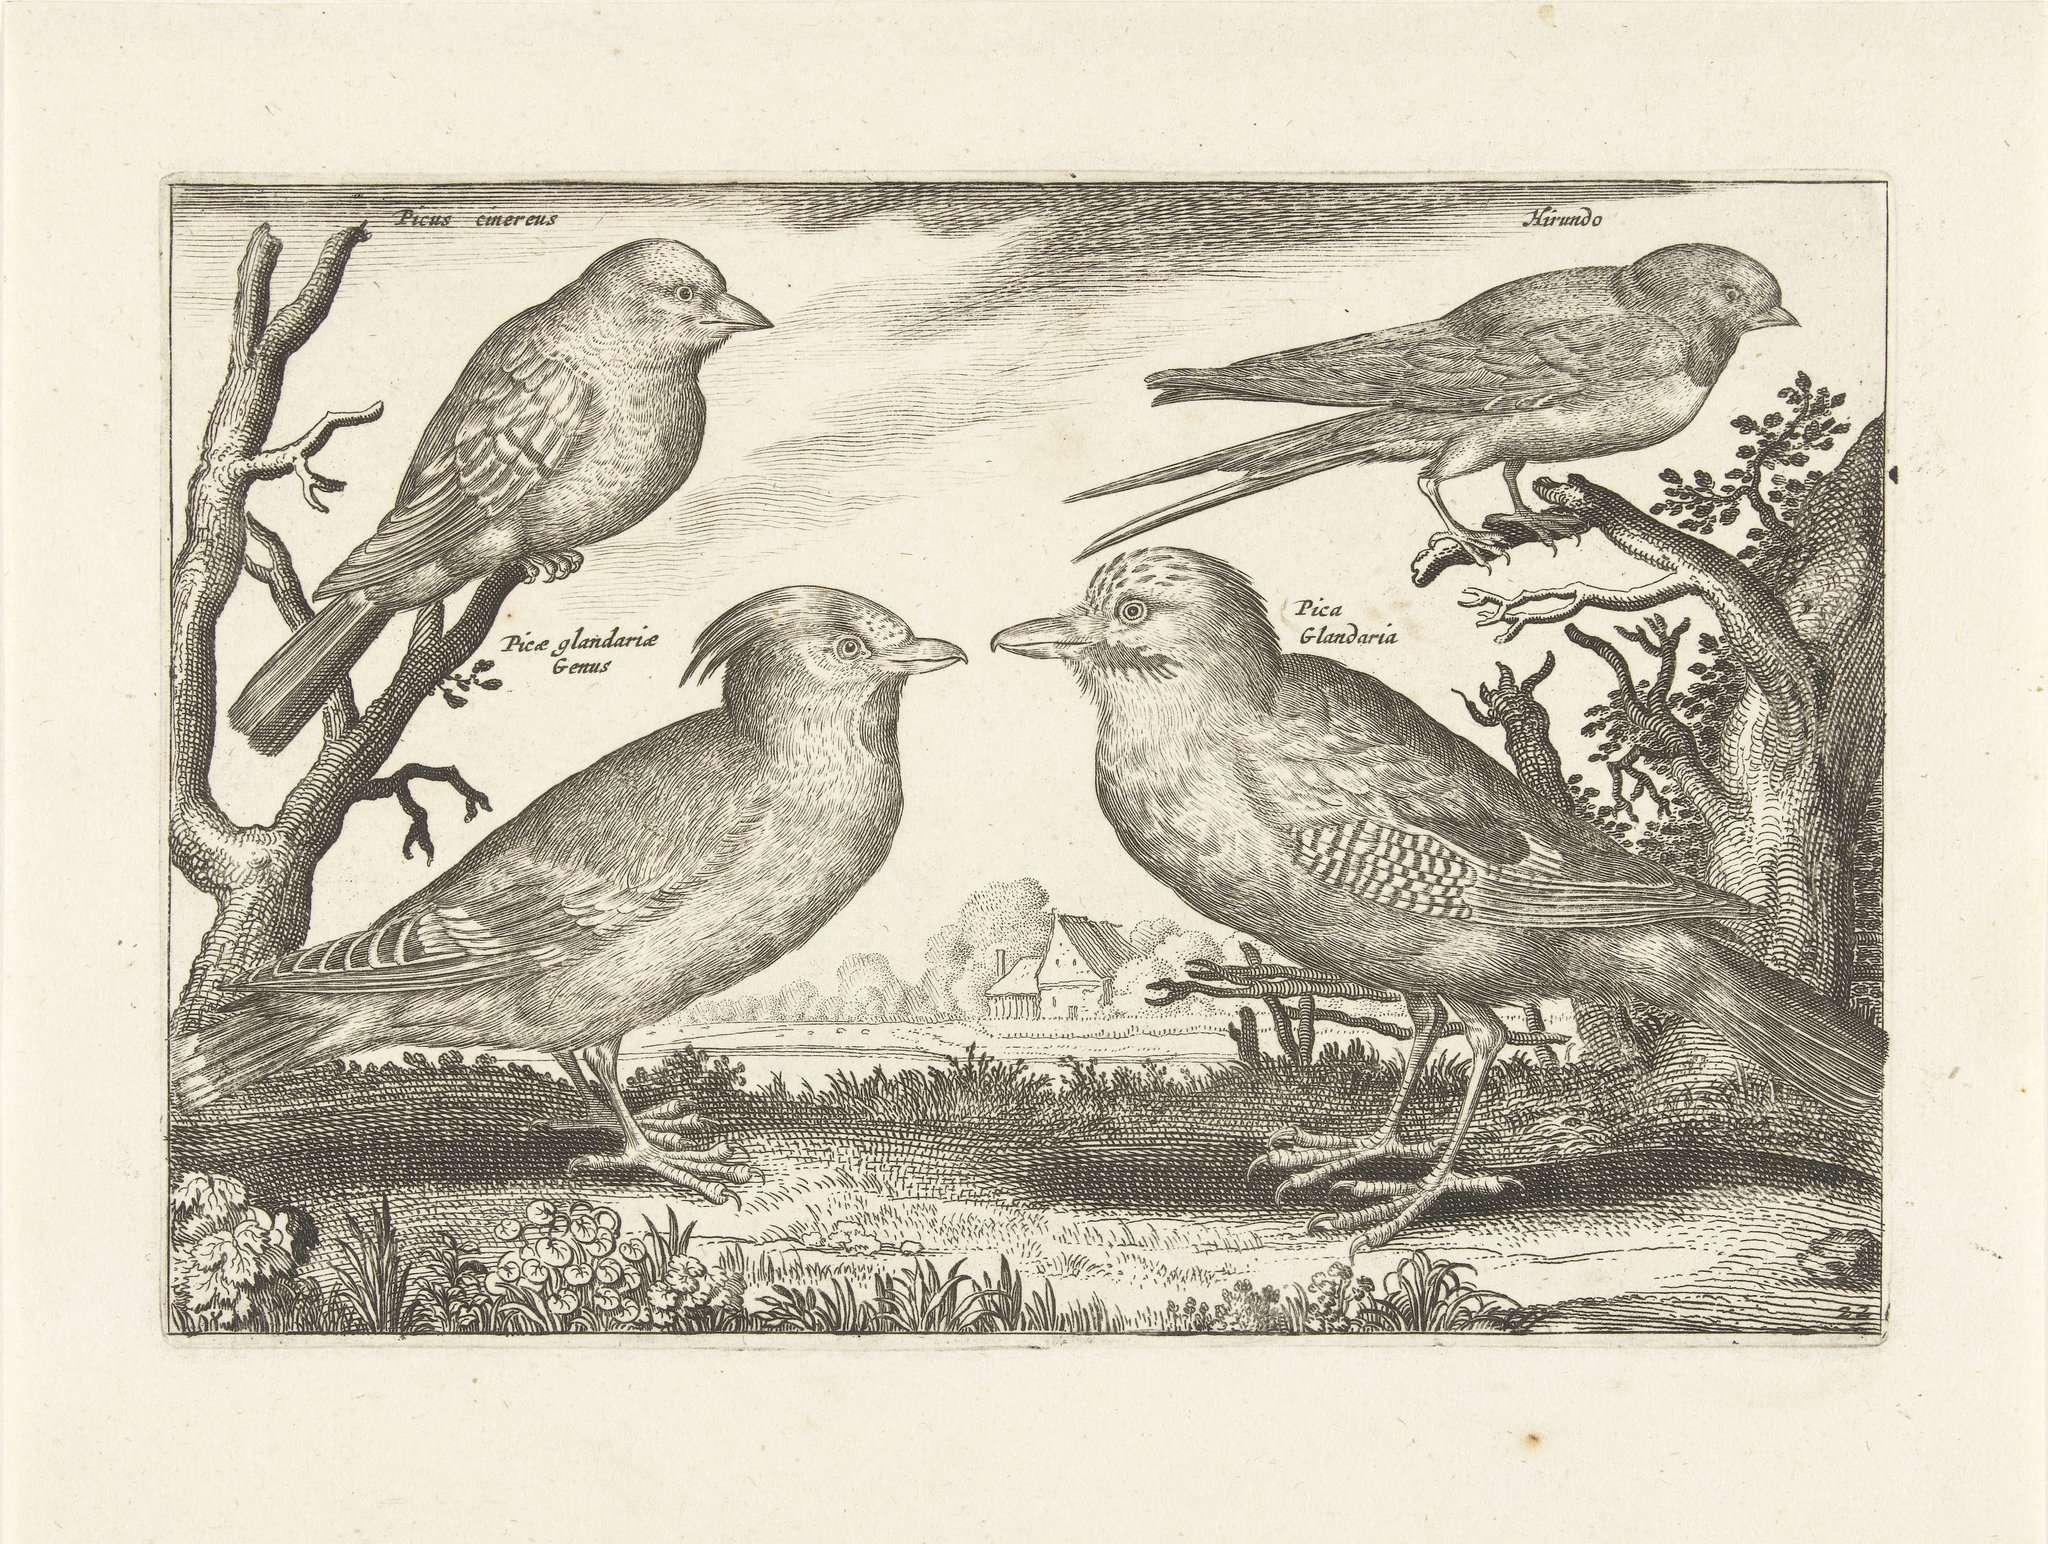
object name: print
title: Avivm Vivae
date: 1659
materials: paper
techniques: engraving, etching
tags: song-birds: swallow, song-birds: finch, song-birds: jay, song-birds: waxtail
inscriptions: collector's mark: Lugt 2228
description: Een Vlaamse gaai, een pestvogel, een vink en een zwaluw. De prent maakt deel uit van een serie met vogels als onderwerp.